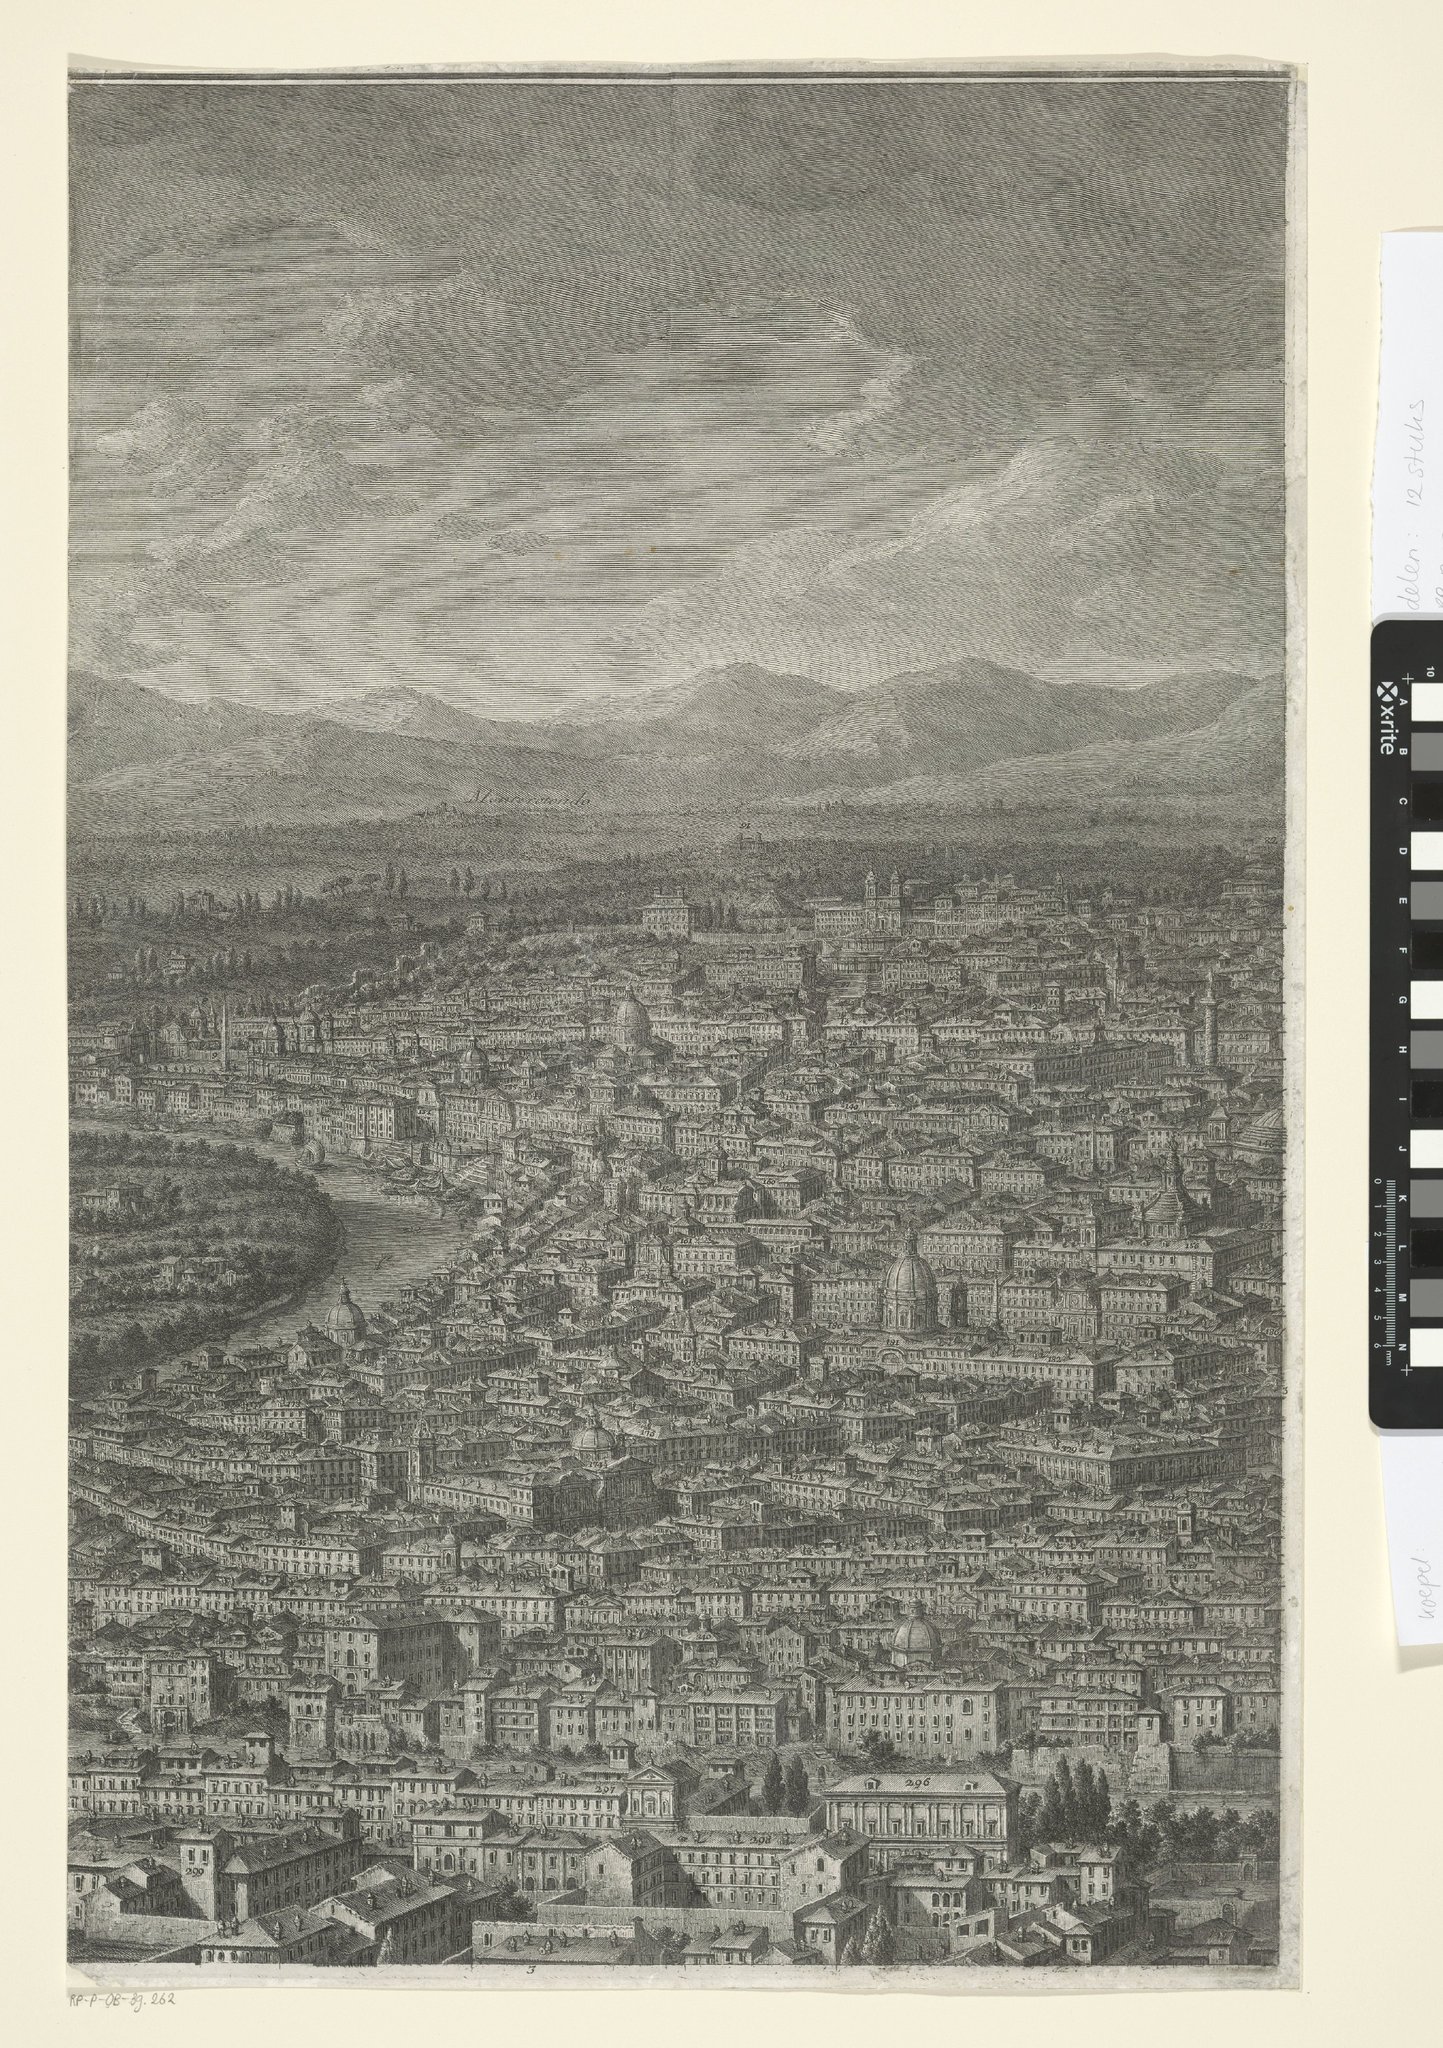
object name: print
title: Panorama van de stad Rome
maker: giuseppe vasi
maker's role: draughtsman, painter, print maker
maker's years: 1710-1782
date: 1765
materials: paper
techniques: etching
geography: rome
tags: panorama, cyclorama, city-view in general; 'veduta', rome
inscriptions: collector's mark: Lugt 2228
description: Deel van een panorama van de stad Rome, gezien vanaf de Janiculum heuvel.